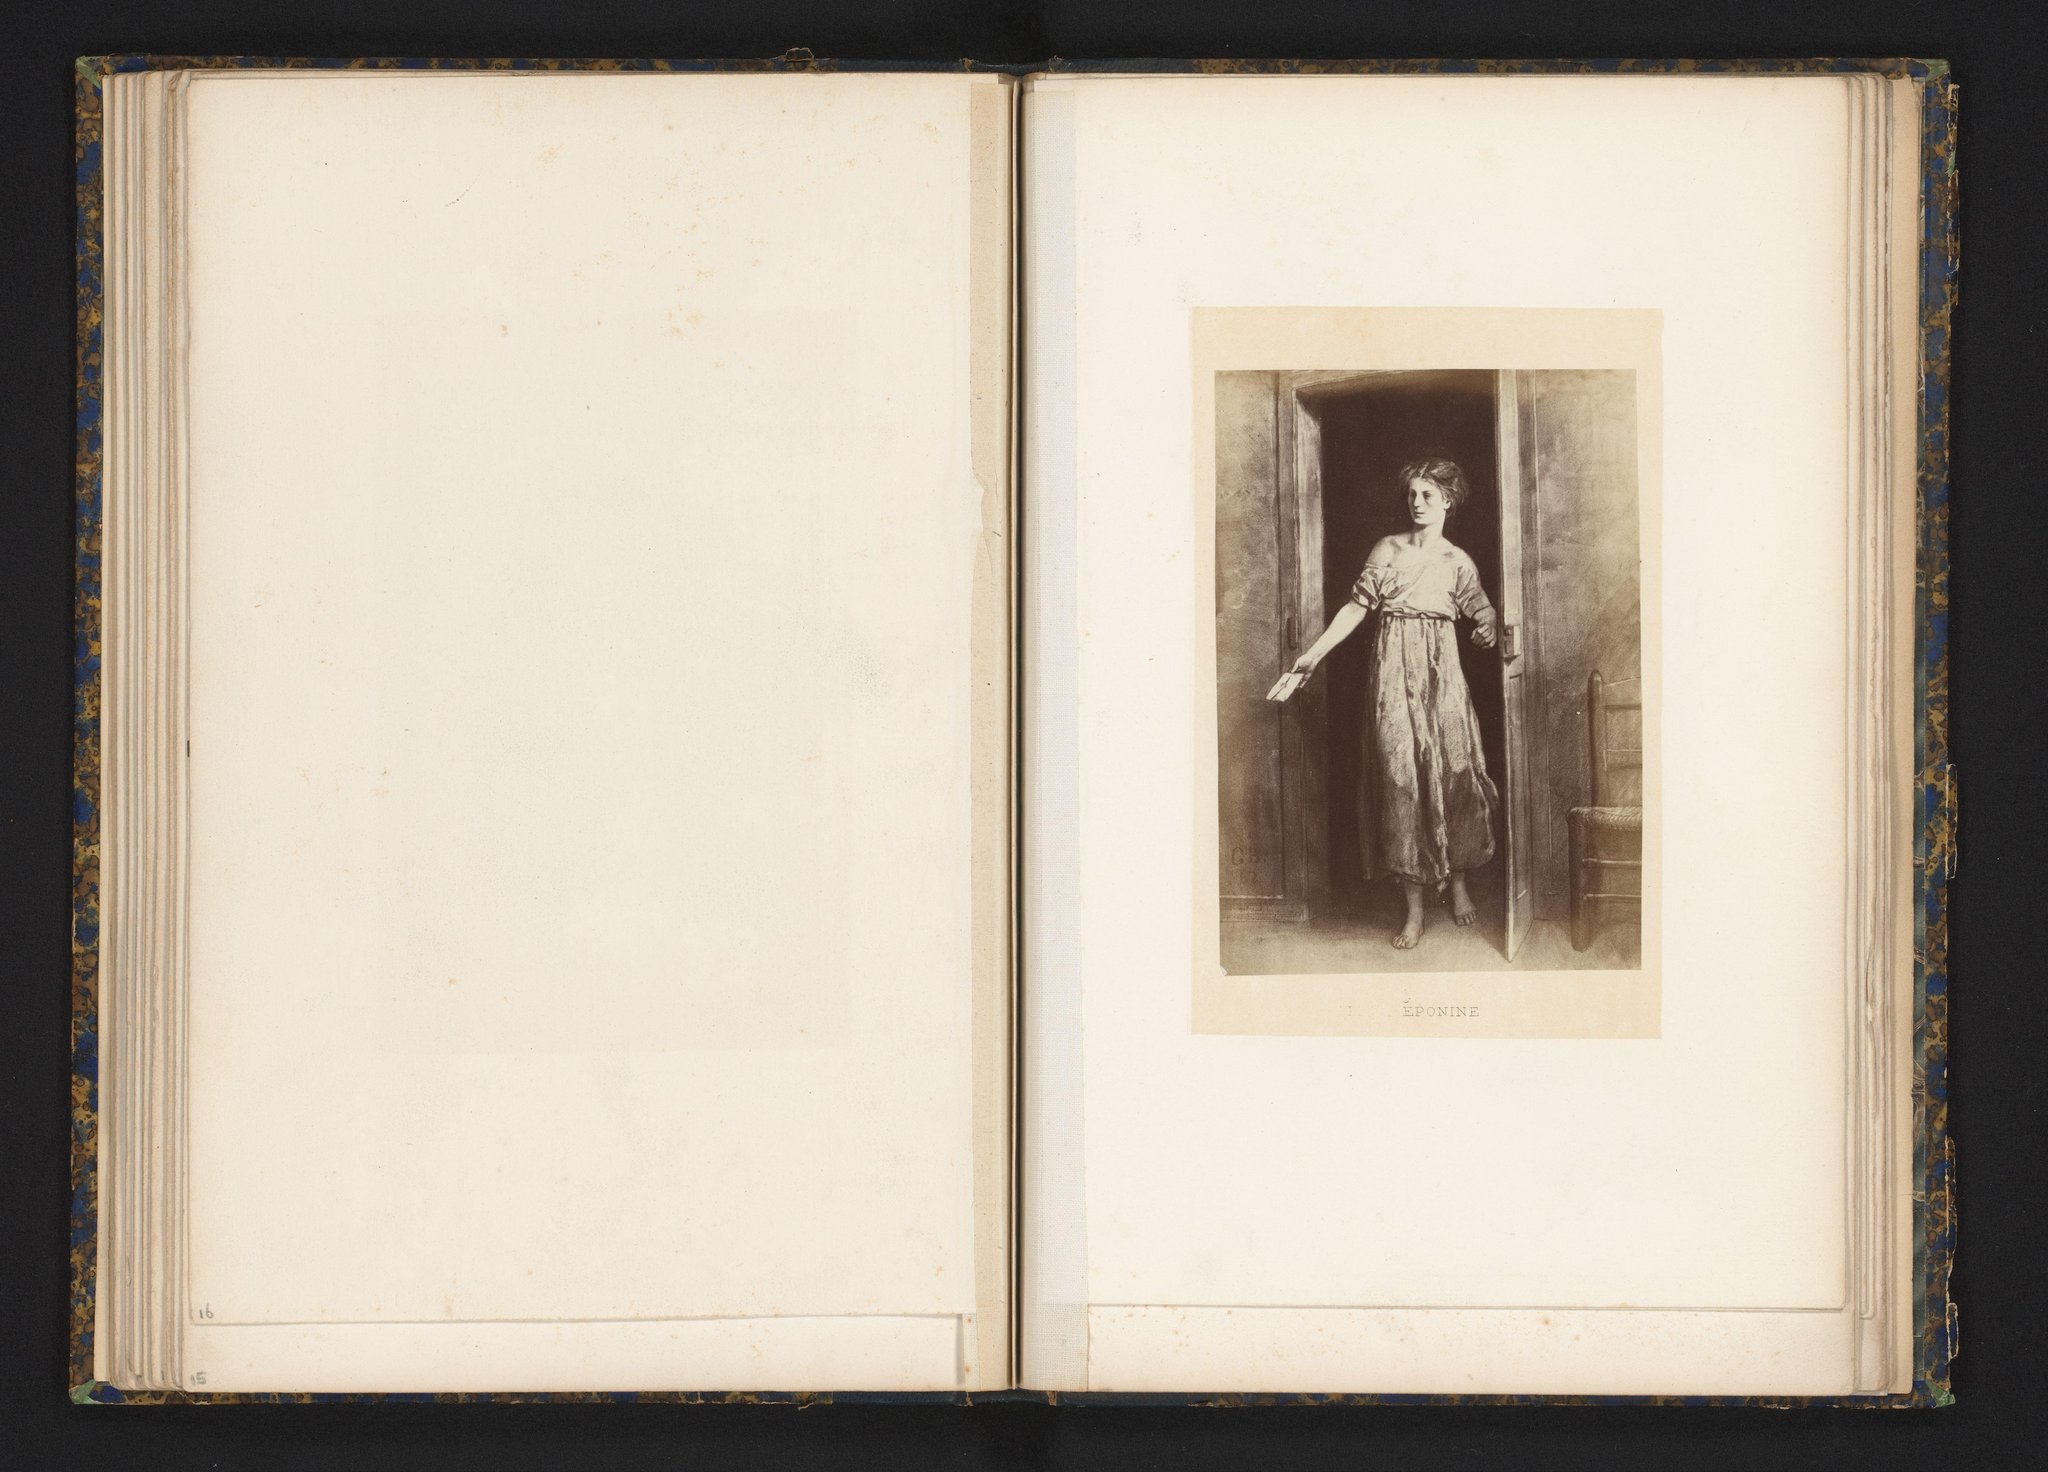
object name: photograph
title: Fotoreproductie van een tekening van Eponine uit Les Misérables van Victor Hugo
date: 1862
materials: photographic support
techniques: albumen print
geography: paris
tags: literary characters and objects